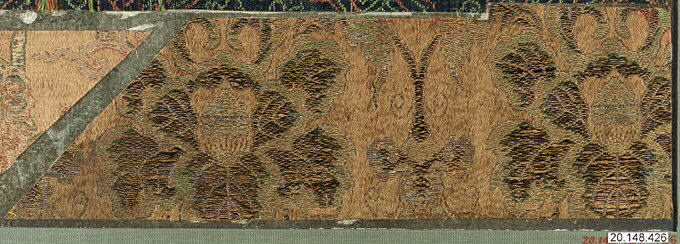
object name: piece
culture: japanese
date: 1601-1700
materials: silk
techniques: compound weave